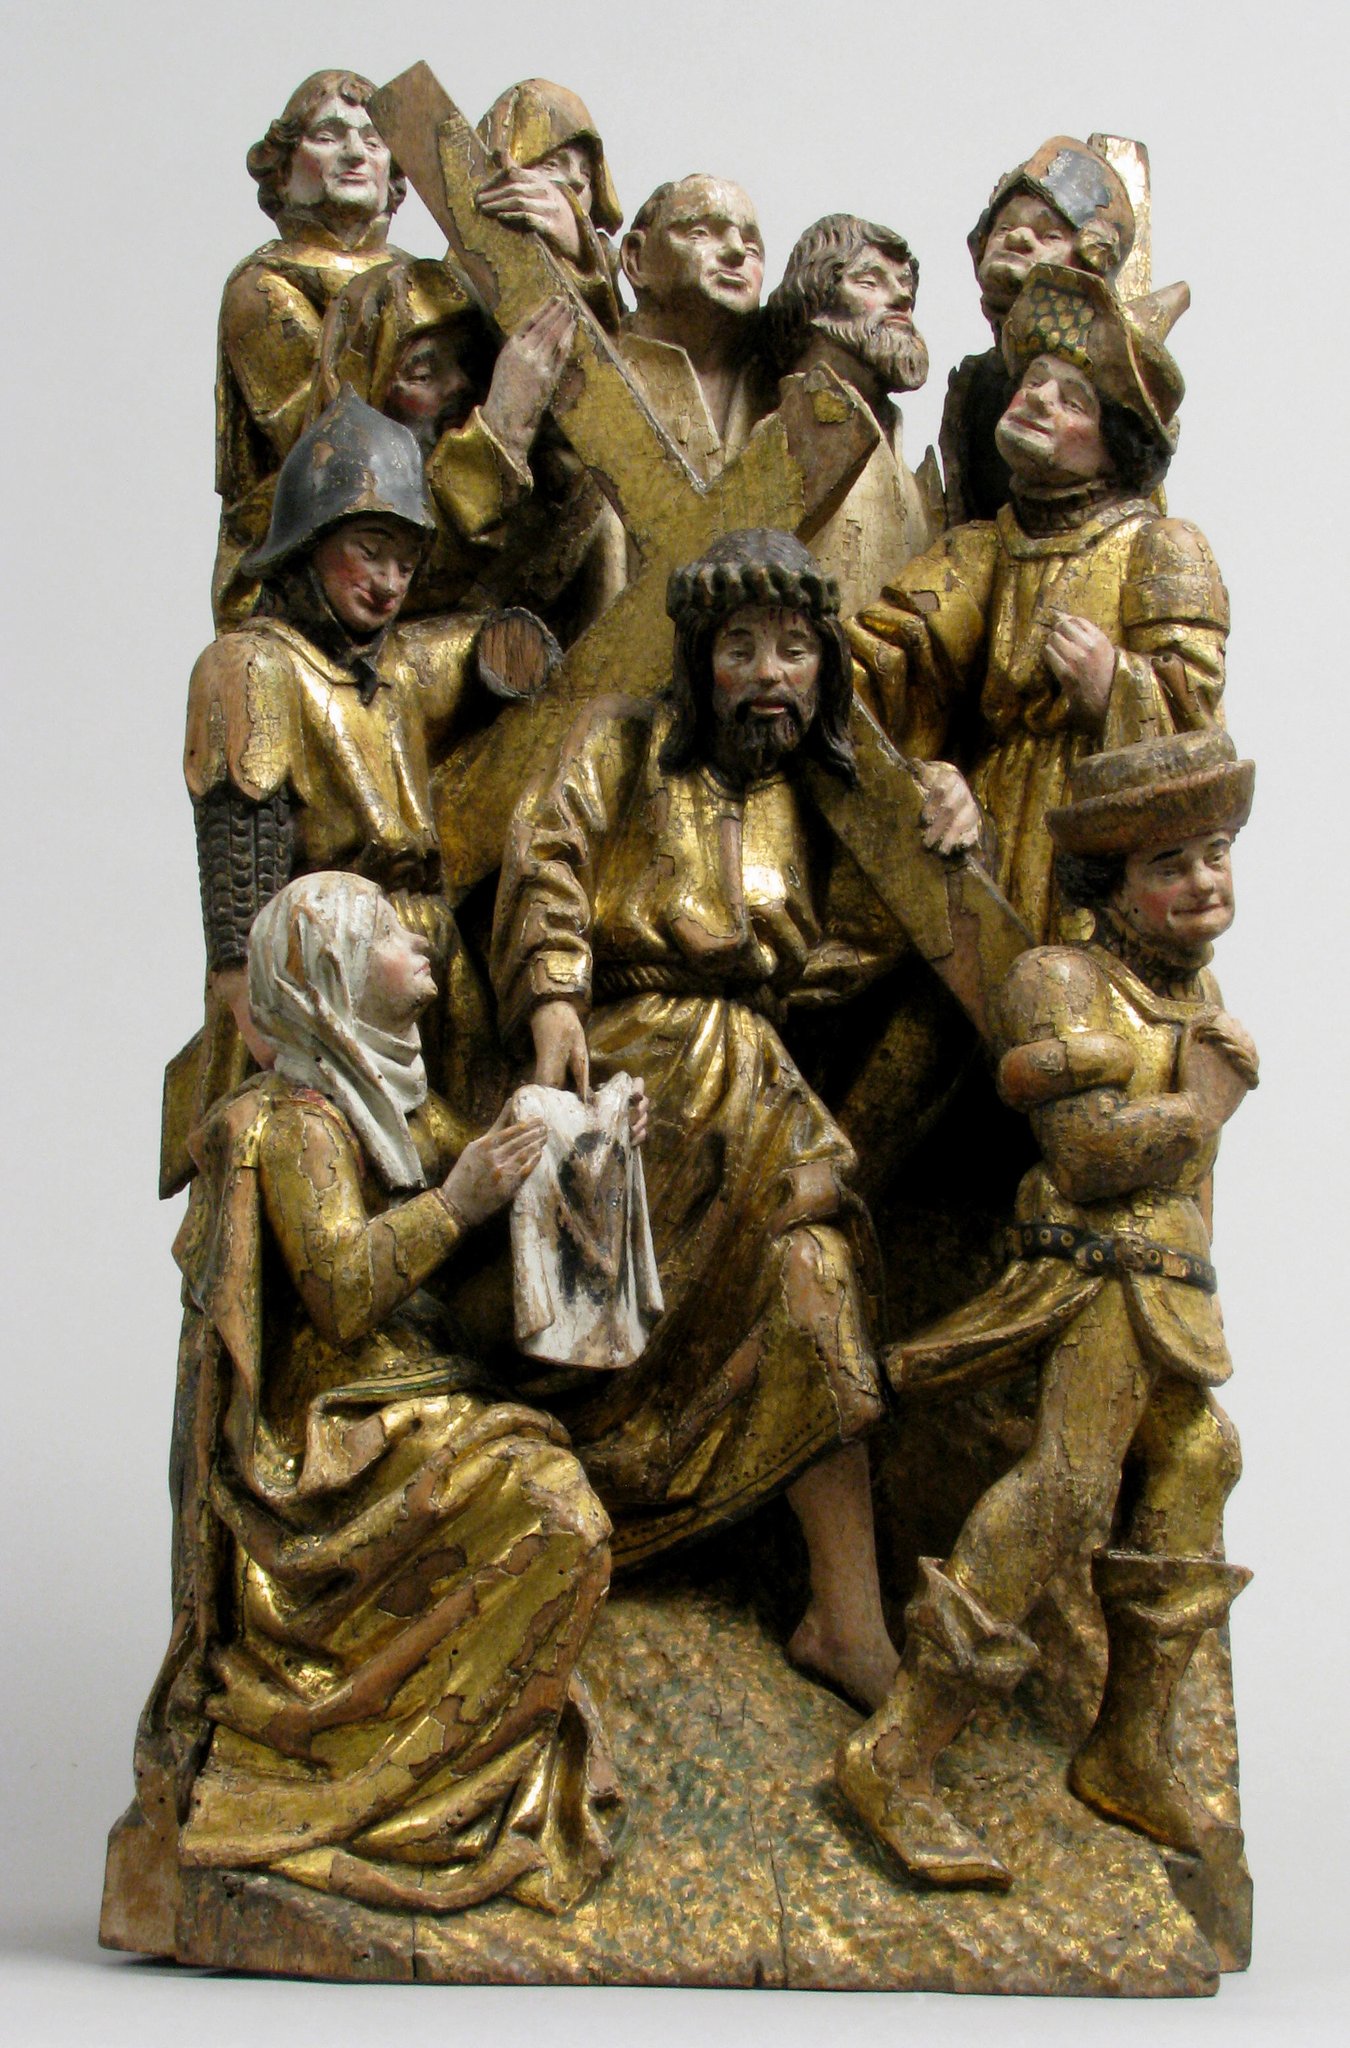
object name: relief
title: The Way to Calvary, with Saint Veronica Receiving the Veil Imprinted with the Face of Christ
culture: south netherlandish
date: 1510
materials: paint, wood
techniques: gilding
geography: netherlands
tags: men,cross,saints